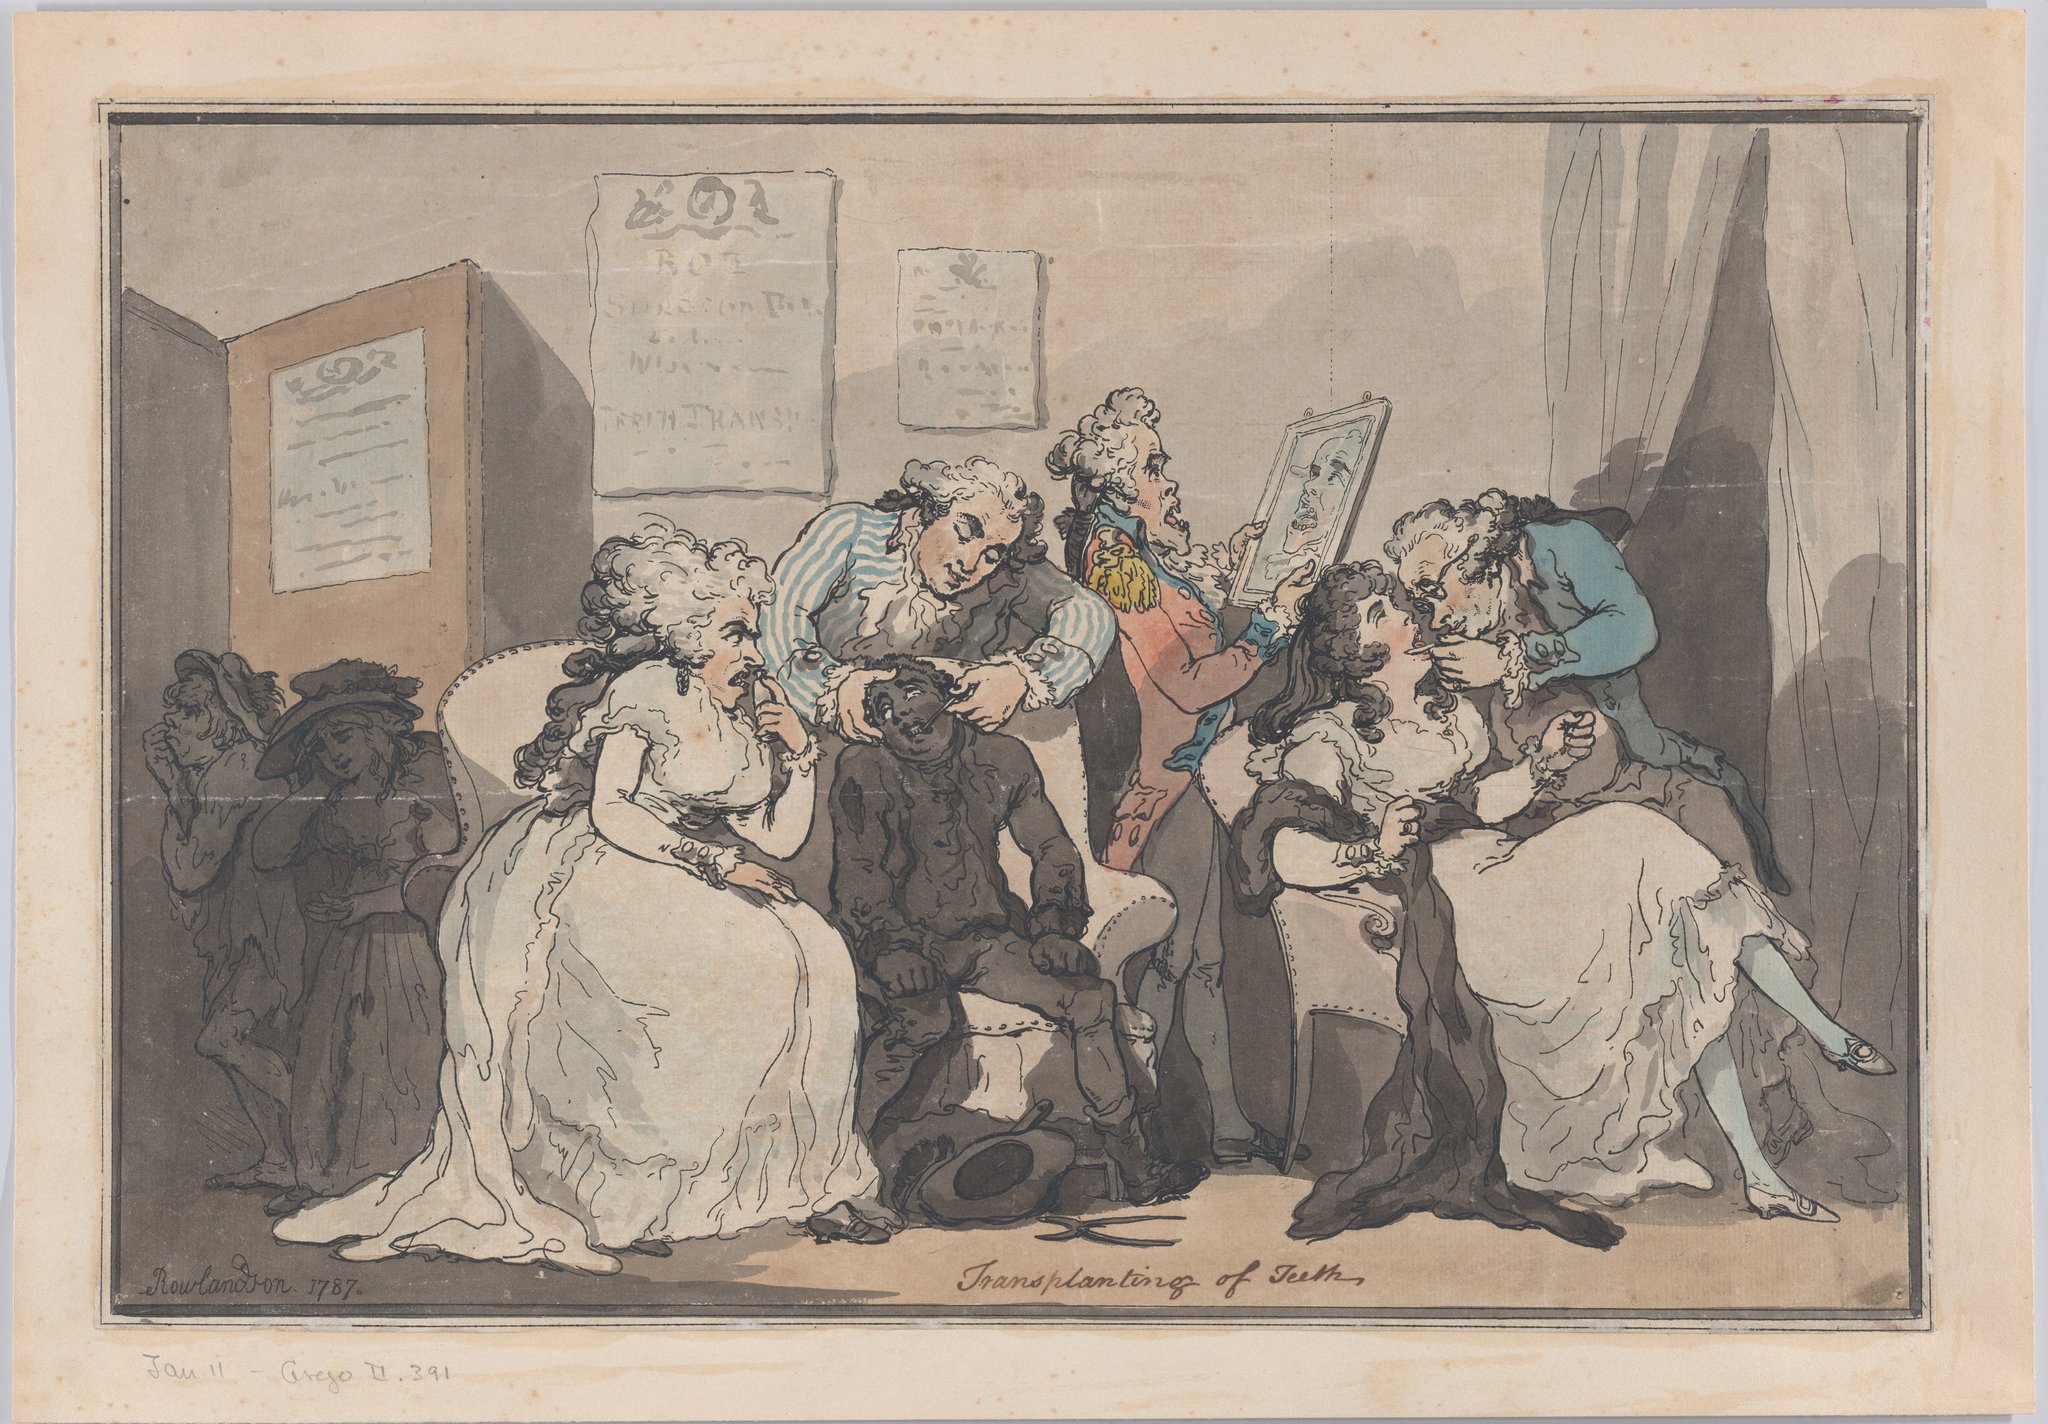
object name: print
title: Transplanting of Teeth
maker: thomas rowlandson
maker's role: artist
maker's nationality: british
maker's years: 1757-1827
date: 1787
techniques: aquatint, etching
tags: satire,men,women,doctors